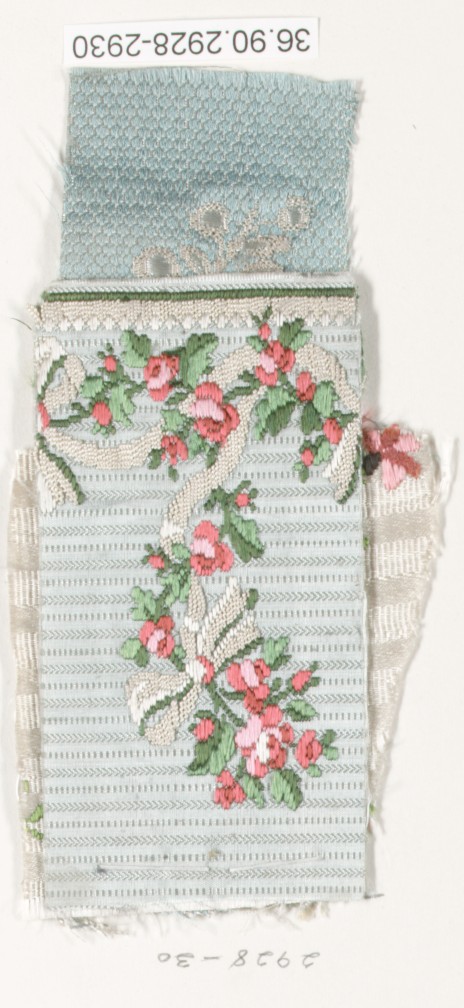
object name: piece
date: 1801-1900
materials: silk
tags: flowers,leaves